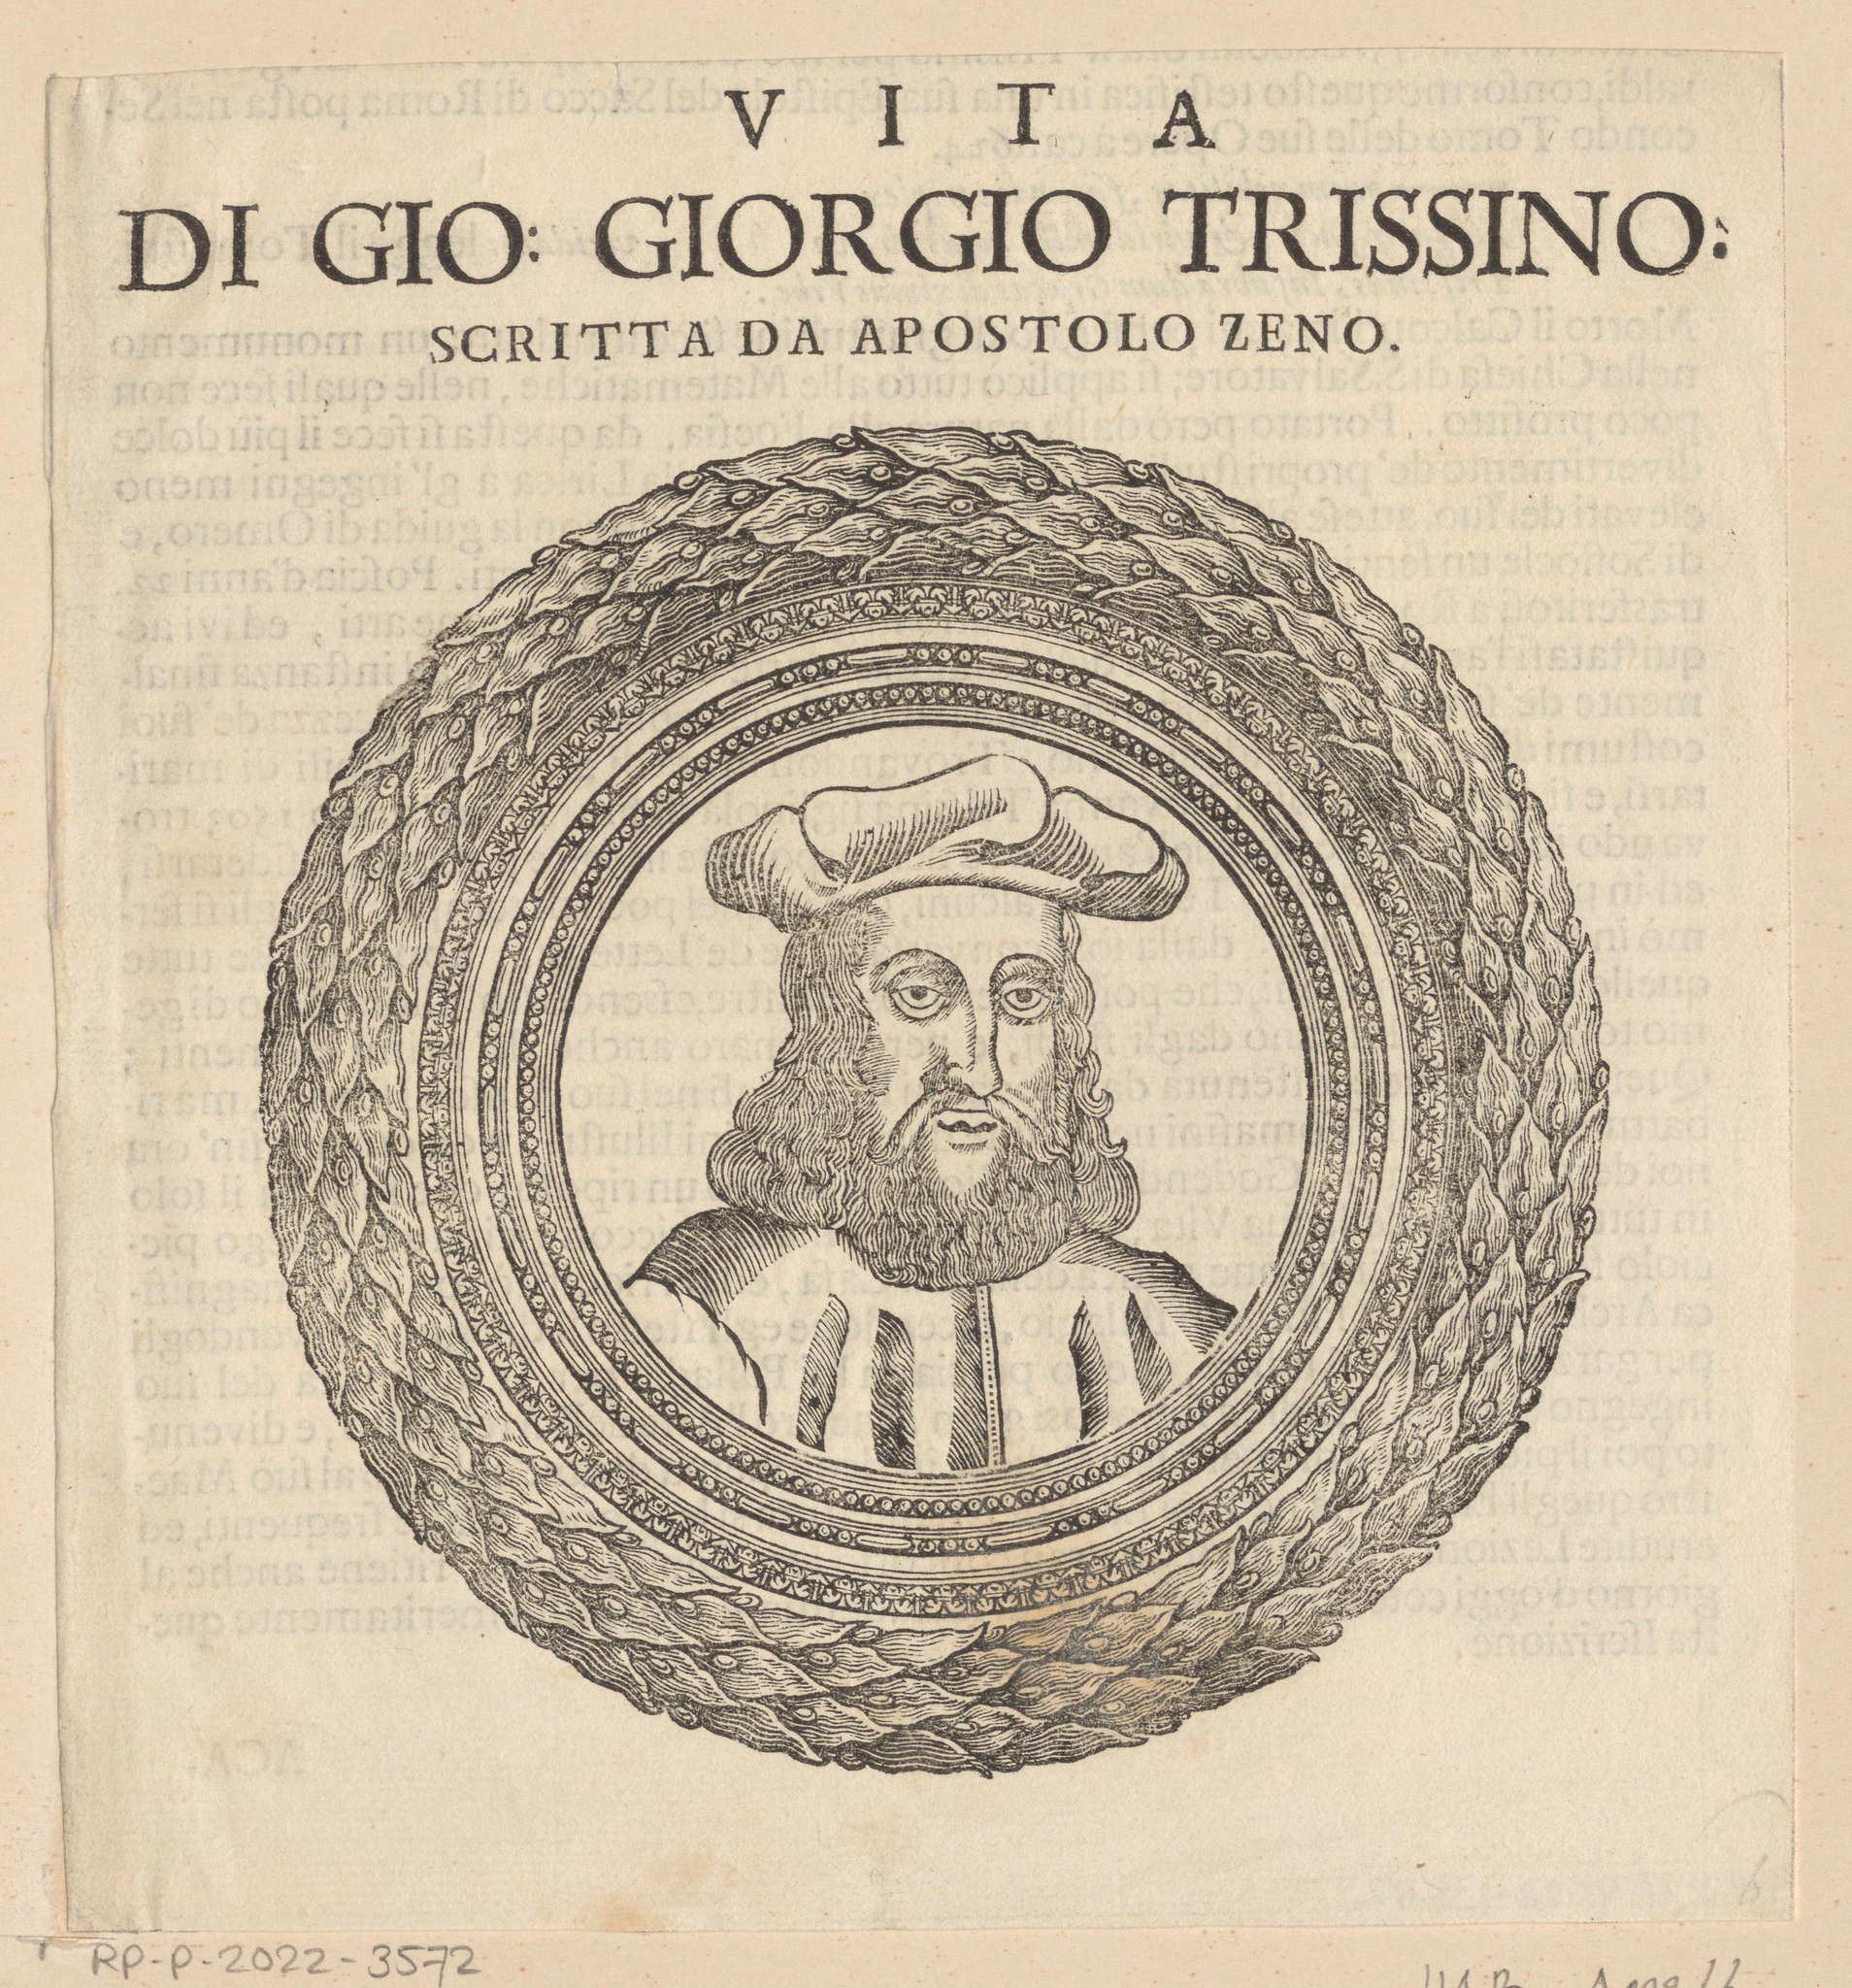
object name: book illustration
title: Portret van Gian Giorgio Trissino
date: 1696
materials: paper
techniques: letterpress printing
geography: italy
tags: rome, official; civil servant; functionary (in general), scholar, philosopher, historical persons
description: Prent uit: La galleria di Minerva overo universali (...). Venetië: Girolamo Albrizzi, 1696, p. 65.